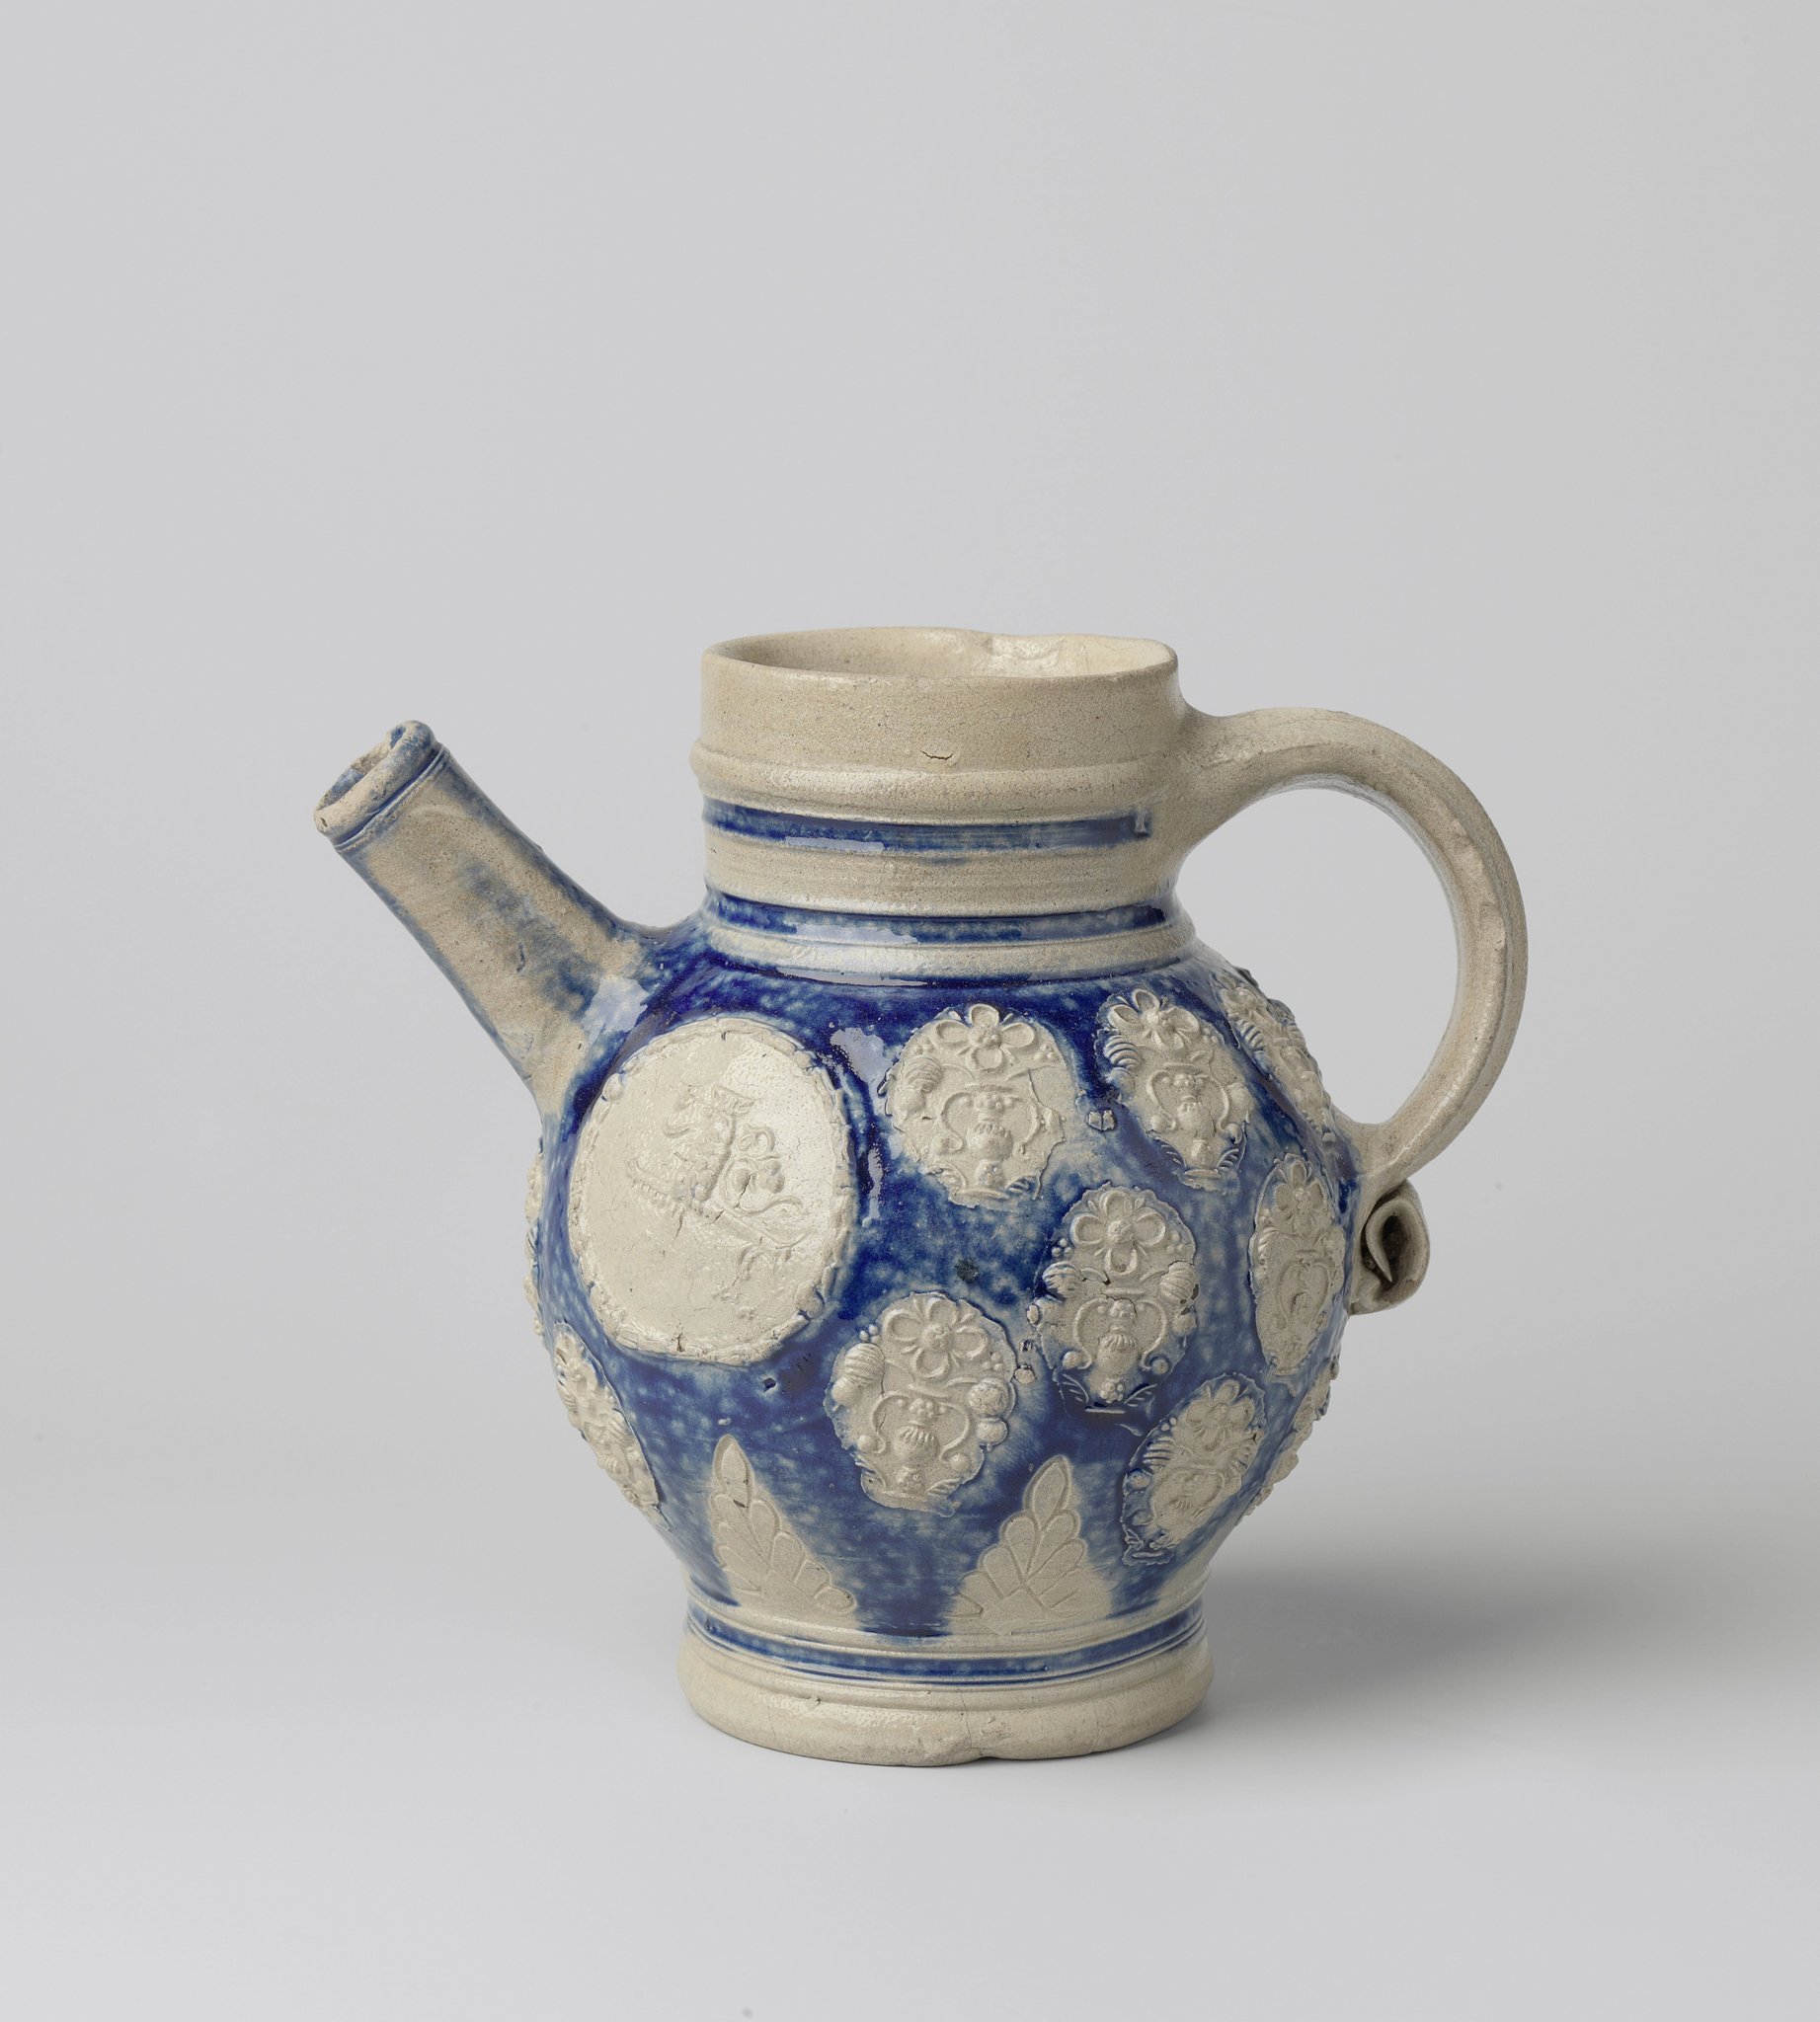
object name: ewer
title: Jug with lions, flower vazes and stylized leaves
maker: Anonymous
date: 1650-1699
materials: cobalt, glaze, stoneware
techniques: printing, firing, forming, relief, turning, vitrification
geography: westerwald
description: Kan van steengoed op hoge voet met een bolvormige buik, korte nek en rechte tuit vanuit de schouder. Het C-vormige oor is bevestigd aan de nek en de buik. Enkele profielen en ingegrifte lijnen op de voet en nek. Gedeeltelijk bedekt met kobaltblauw. De buik is bedekt met een reliëfdecoratie met aan weerszijden van de tuit een gedrukte en opgelegde medaillon met een leeuw. Daaromheen drie rijen van kleine, opgelegde bloemenvazen. Boven de voet drie gestempelde gestileerde bladmotieven. Westerwald.